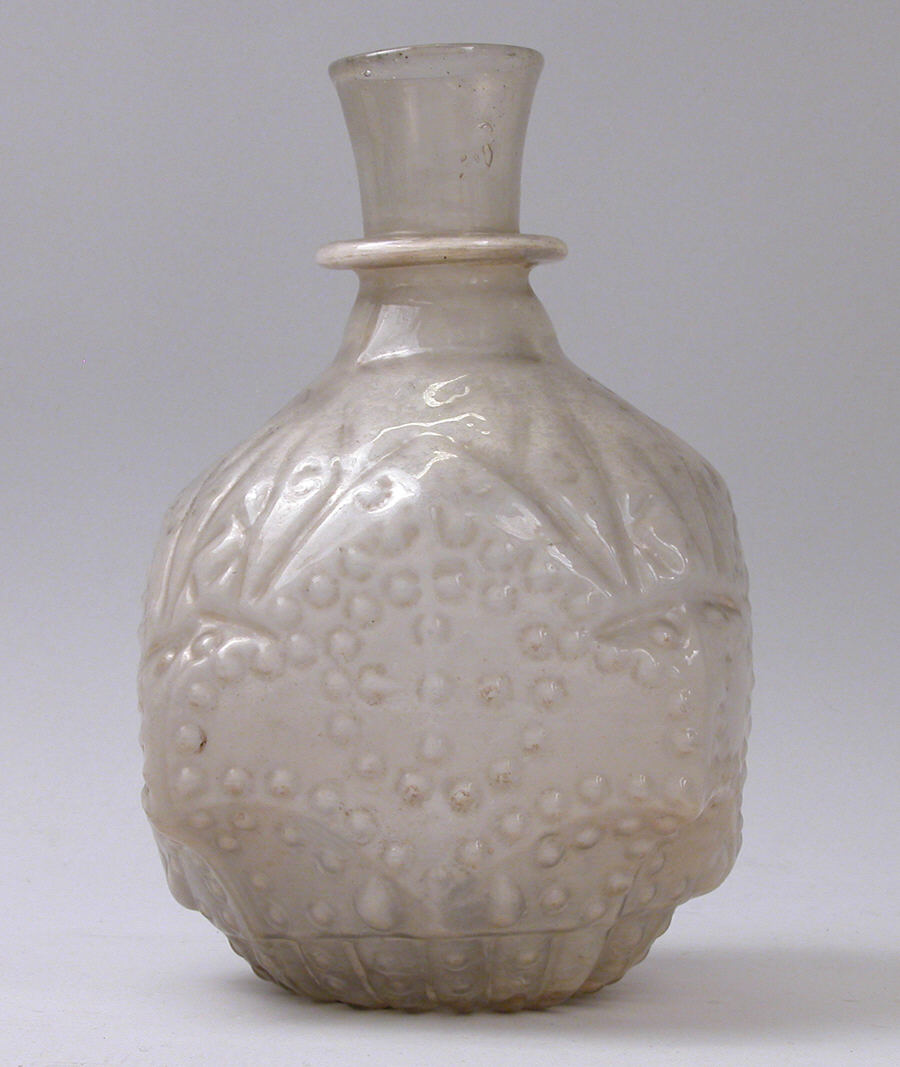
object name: bottle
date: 1701-1900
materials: glass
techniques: glassblowing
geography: iran